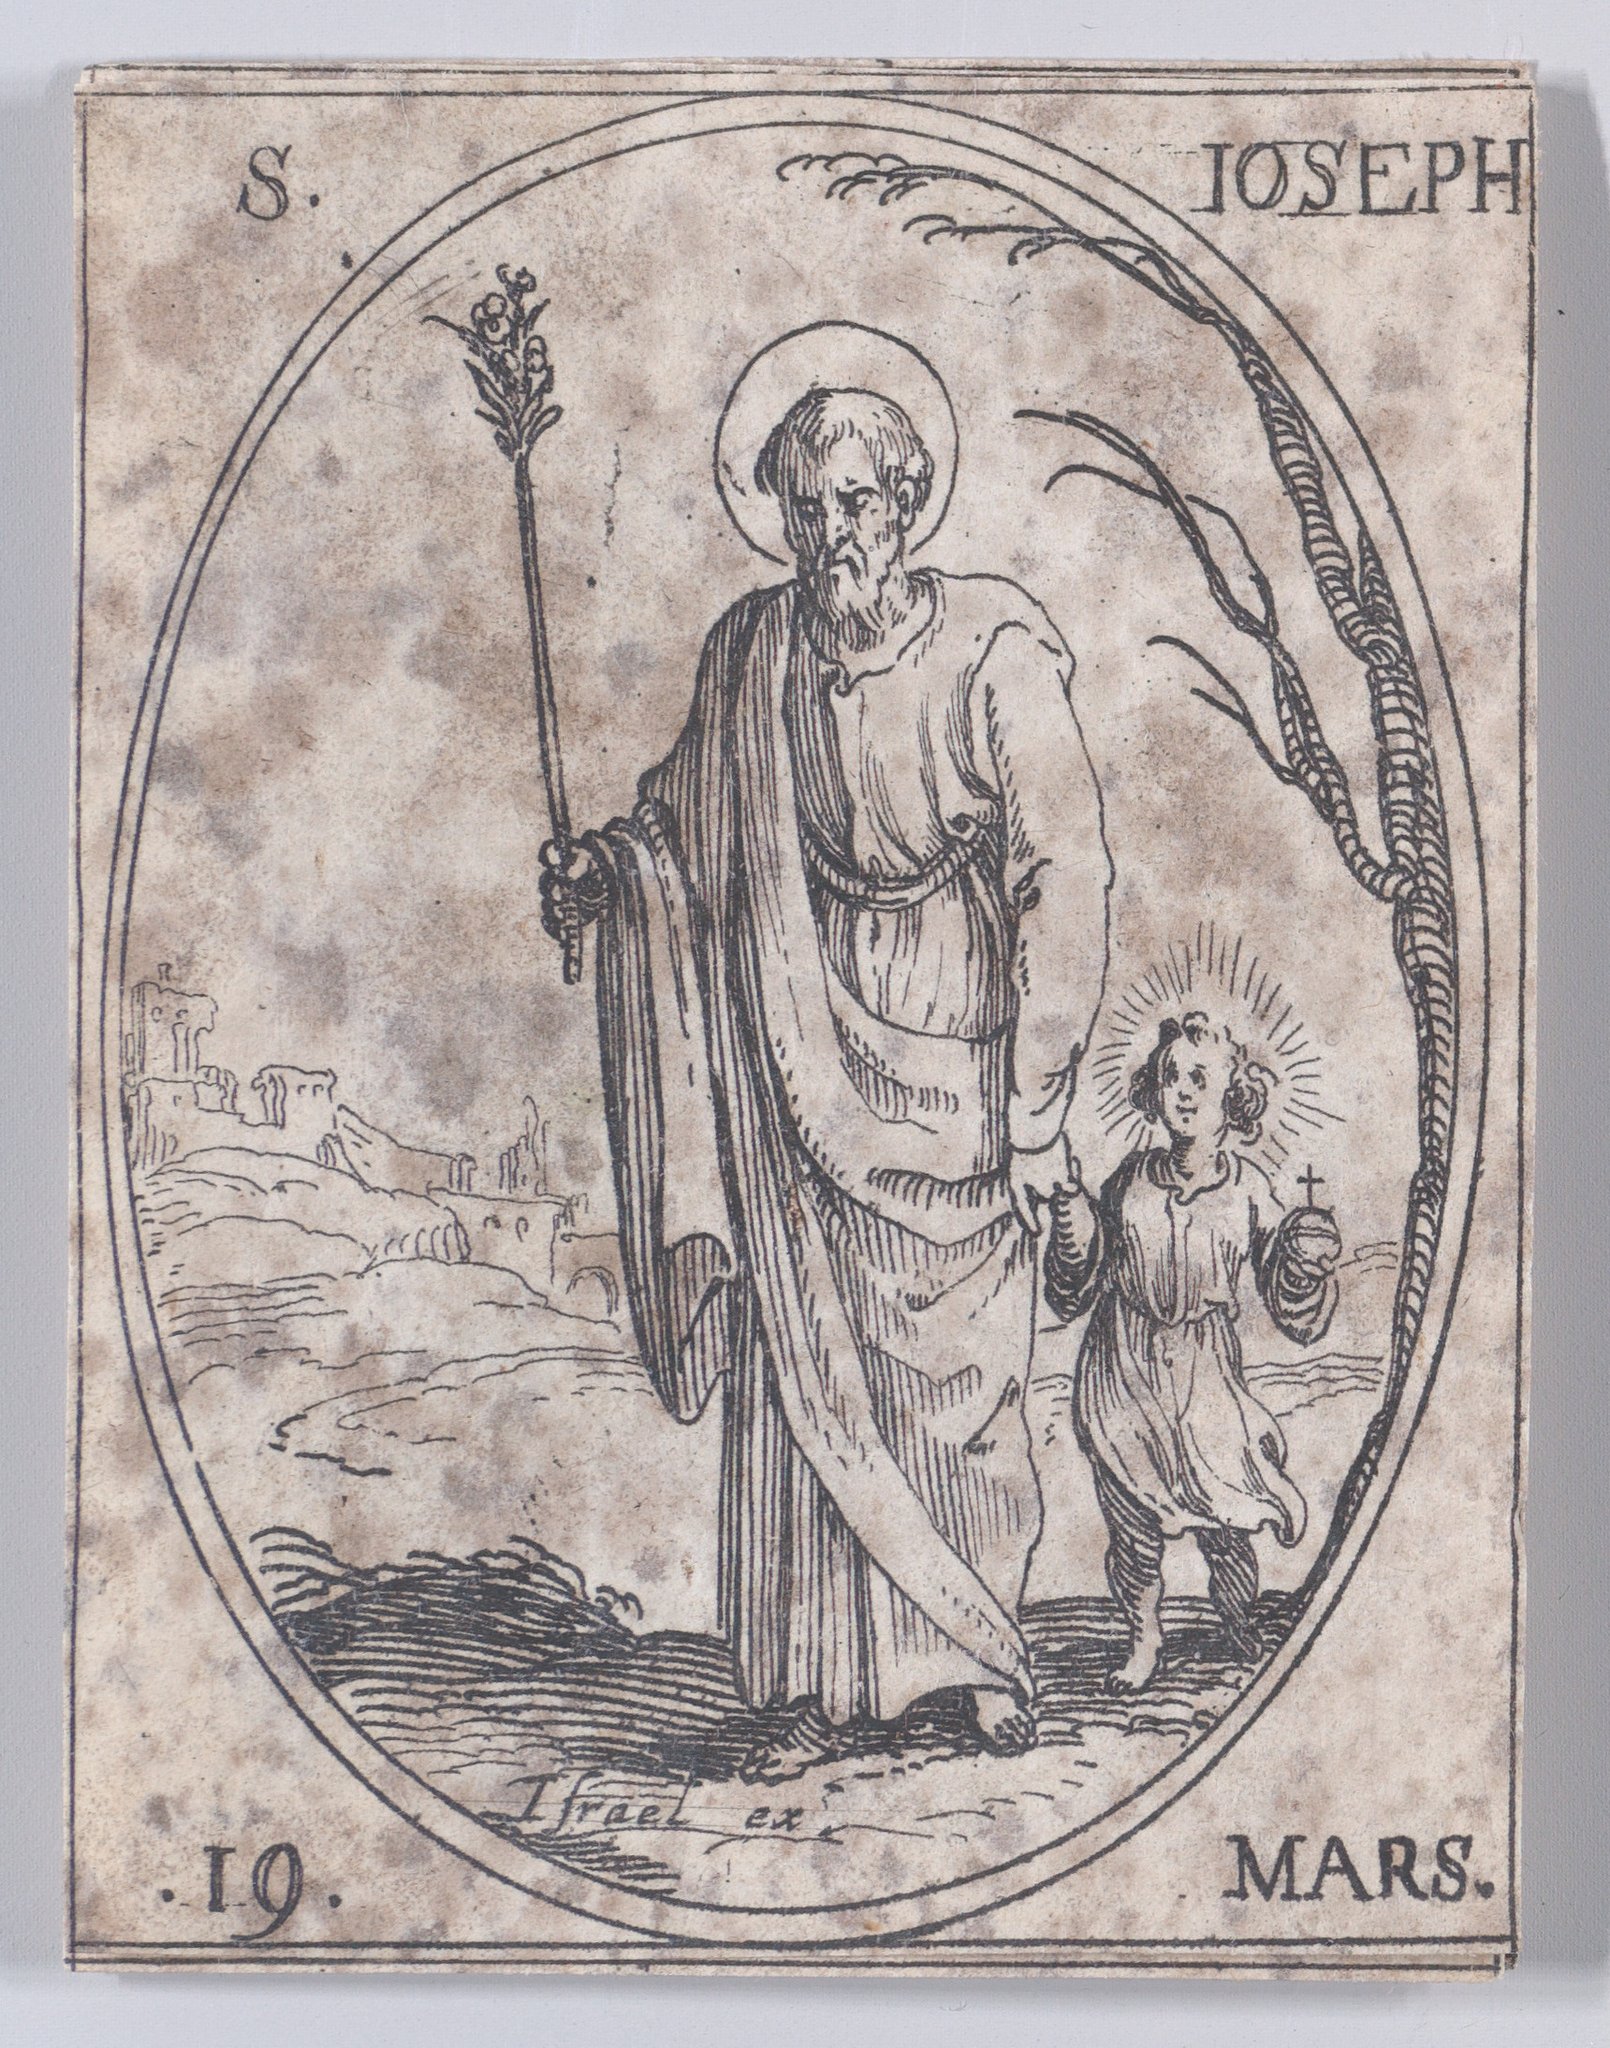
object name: print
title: St. Joseph, March 19th, from "Les Images De Tous Les Saincts et Saintes de L'Année" (Images of All of the Saints and Religious Events of the Year)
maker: jacques callot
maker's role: artist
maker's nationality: french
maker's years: 1592-1635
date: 1636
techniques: etching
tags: men,saints